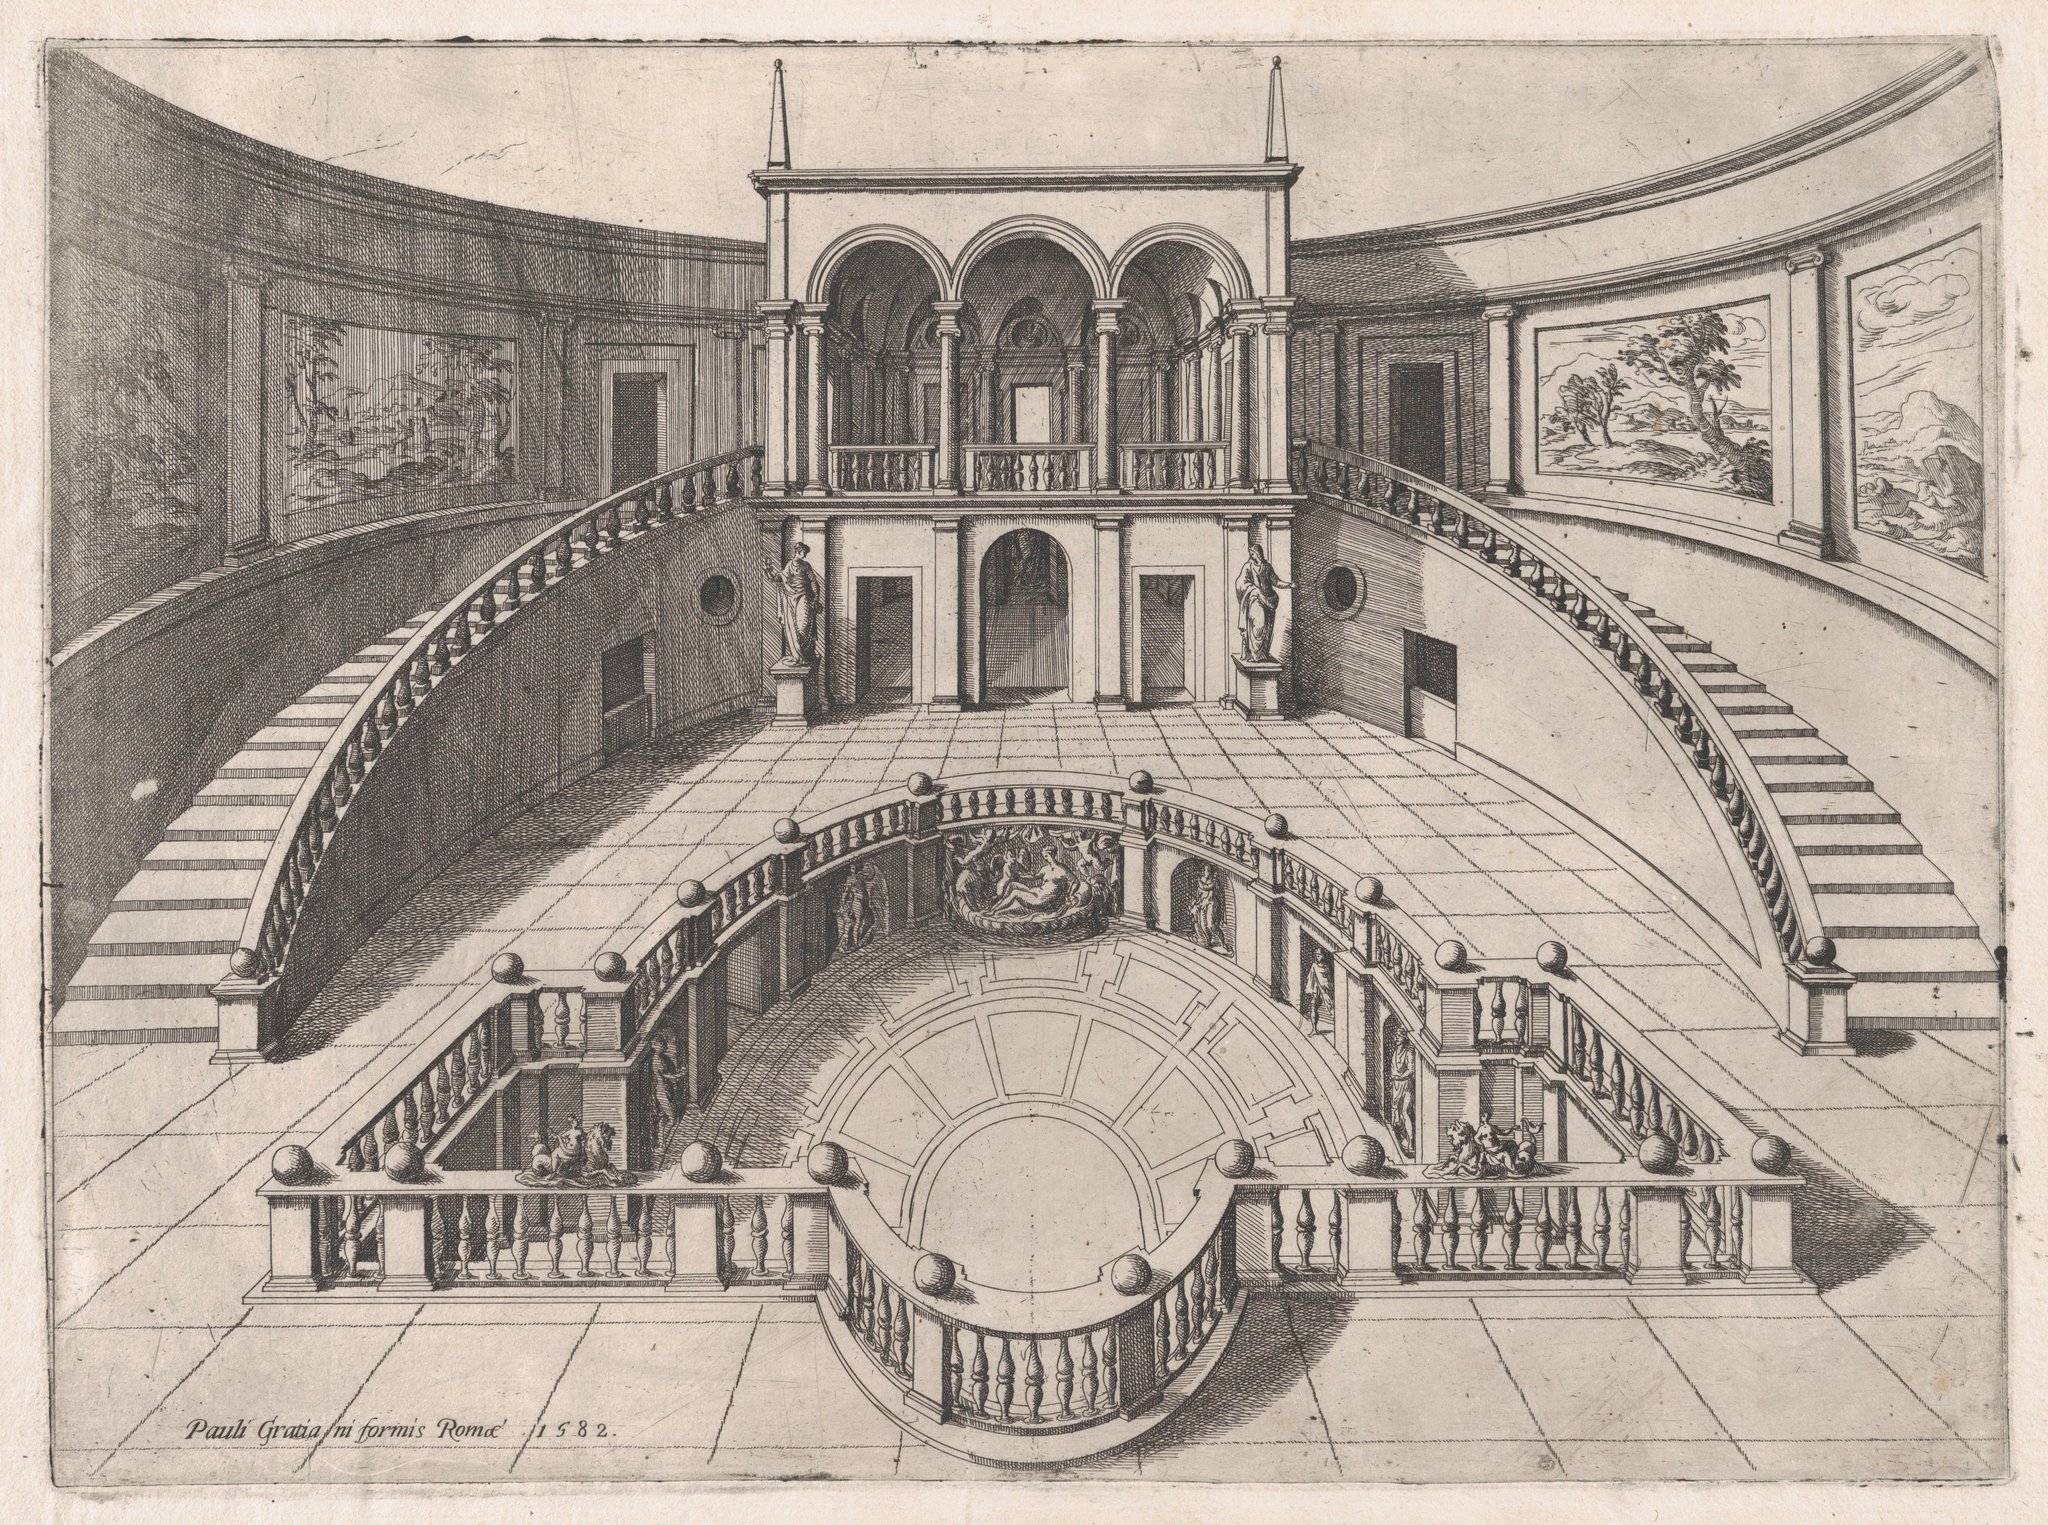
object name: print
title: The Great Hall within the Farnese Palace, from "Speculum Romanae Magnificentiae"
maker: Anonymous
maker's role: artist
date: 1567-1600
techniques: engraving, etching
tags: architecture,palaces,stairs,rome